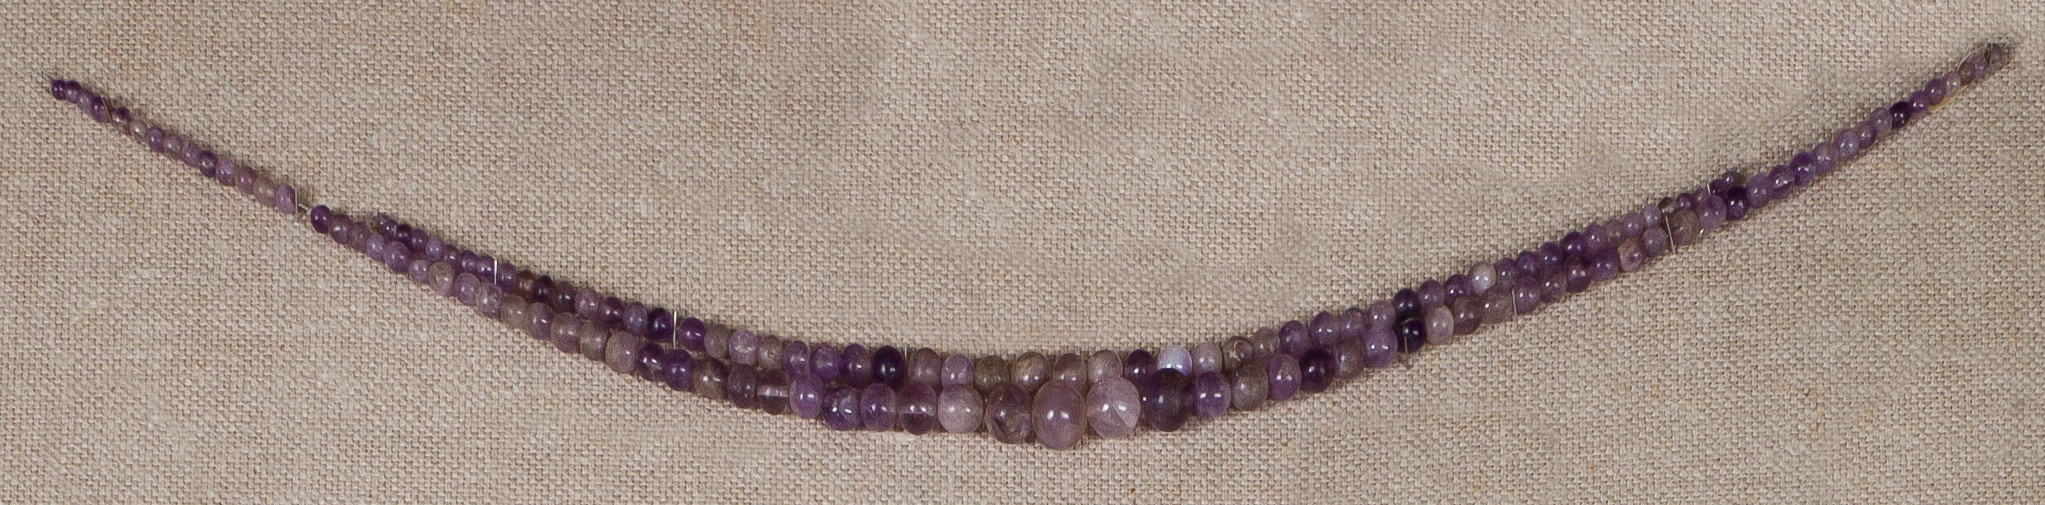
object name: necklace, bead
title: String of beads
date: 1981-1295 BCE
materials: gemstone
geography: egypt